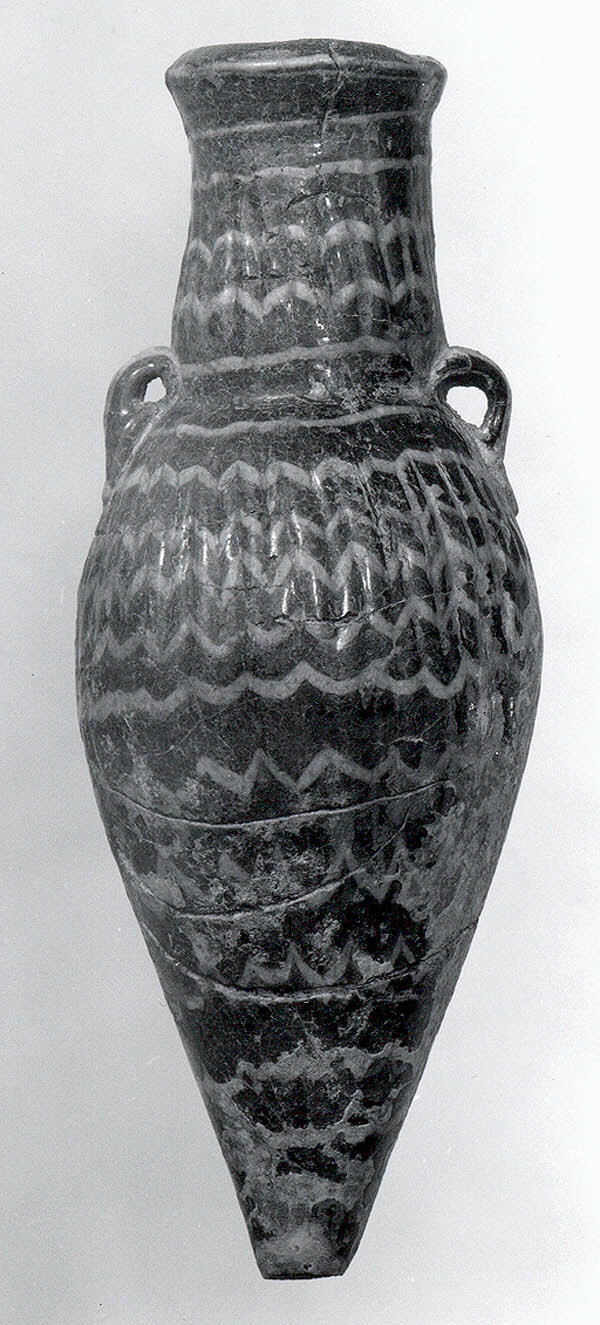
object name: alabastron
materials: glass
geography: mesopotamia